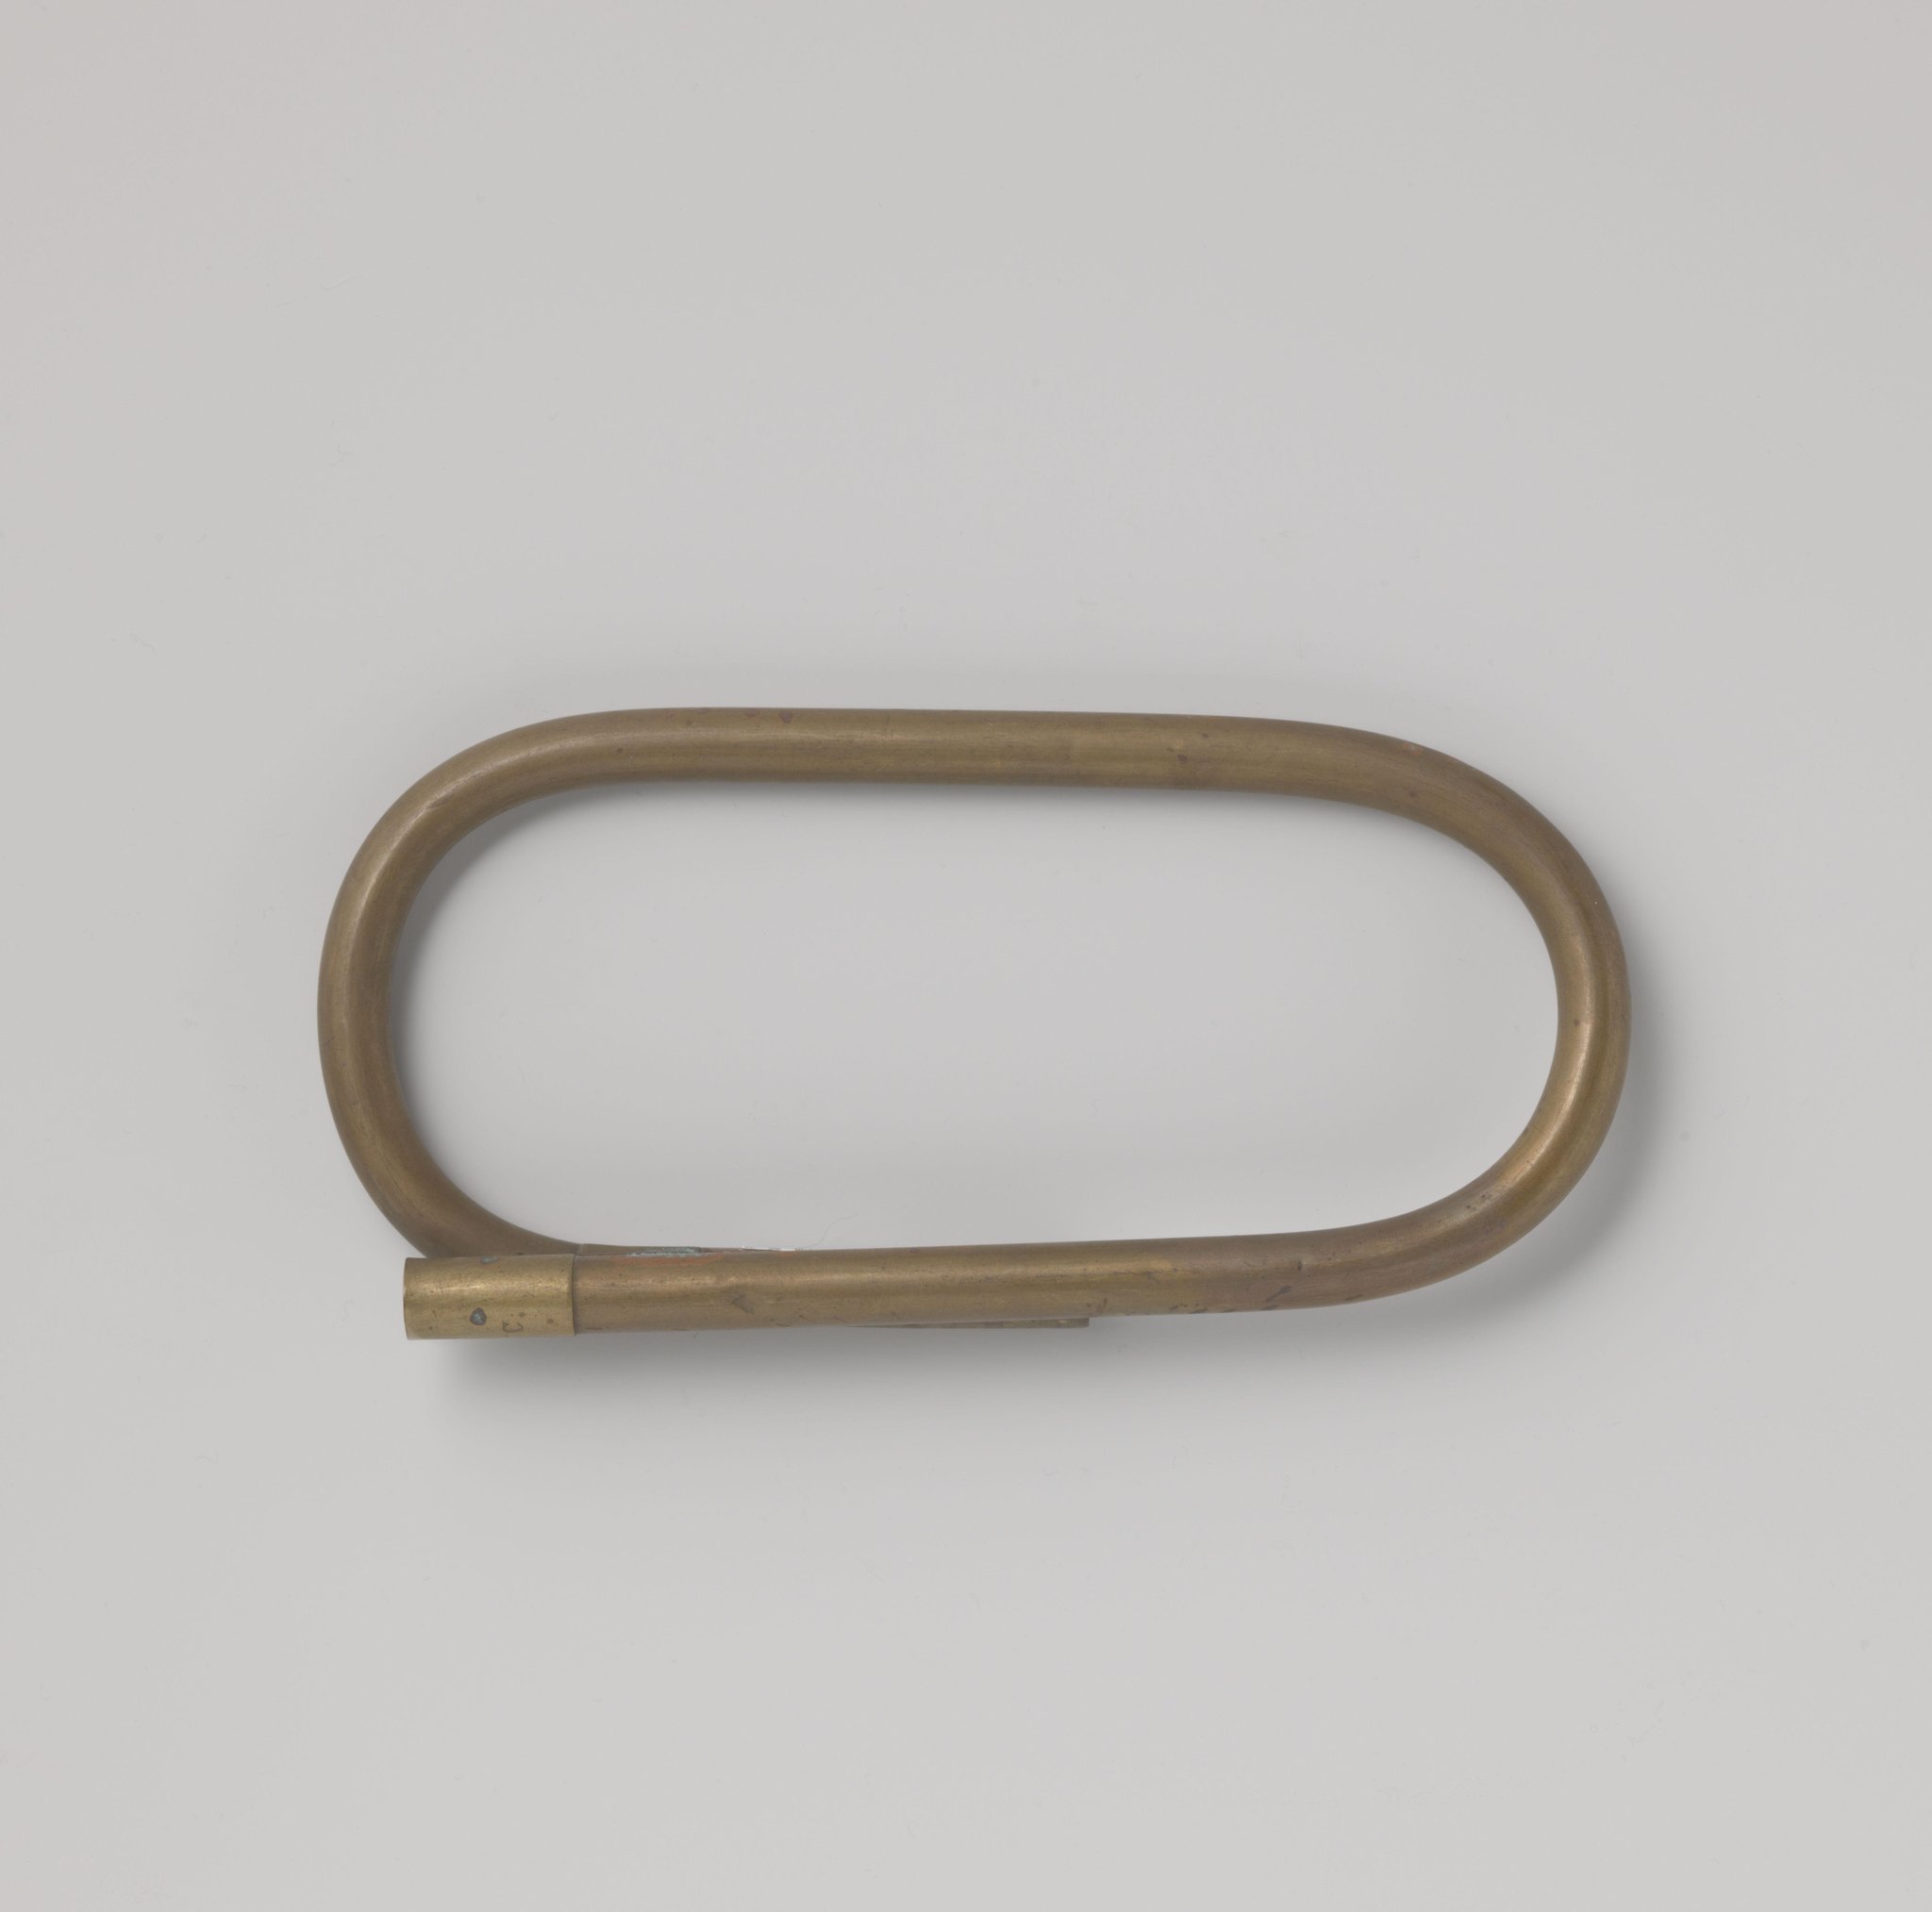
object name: horn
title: Invention horn crook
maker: carl gottlob schüster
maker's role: instrument maker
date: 1850-1950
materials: copper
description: Beugel van inventionshoorn. Niet gemerkt